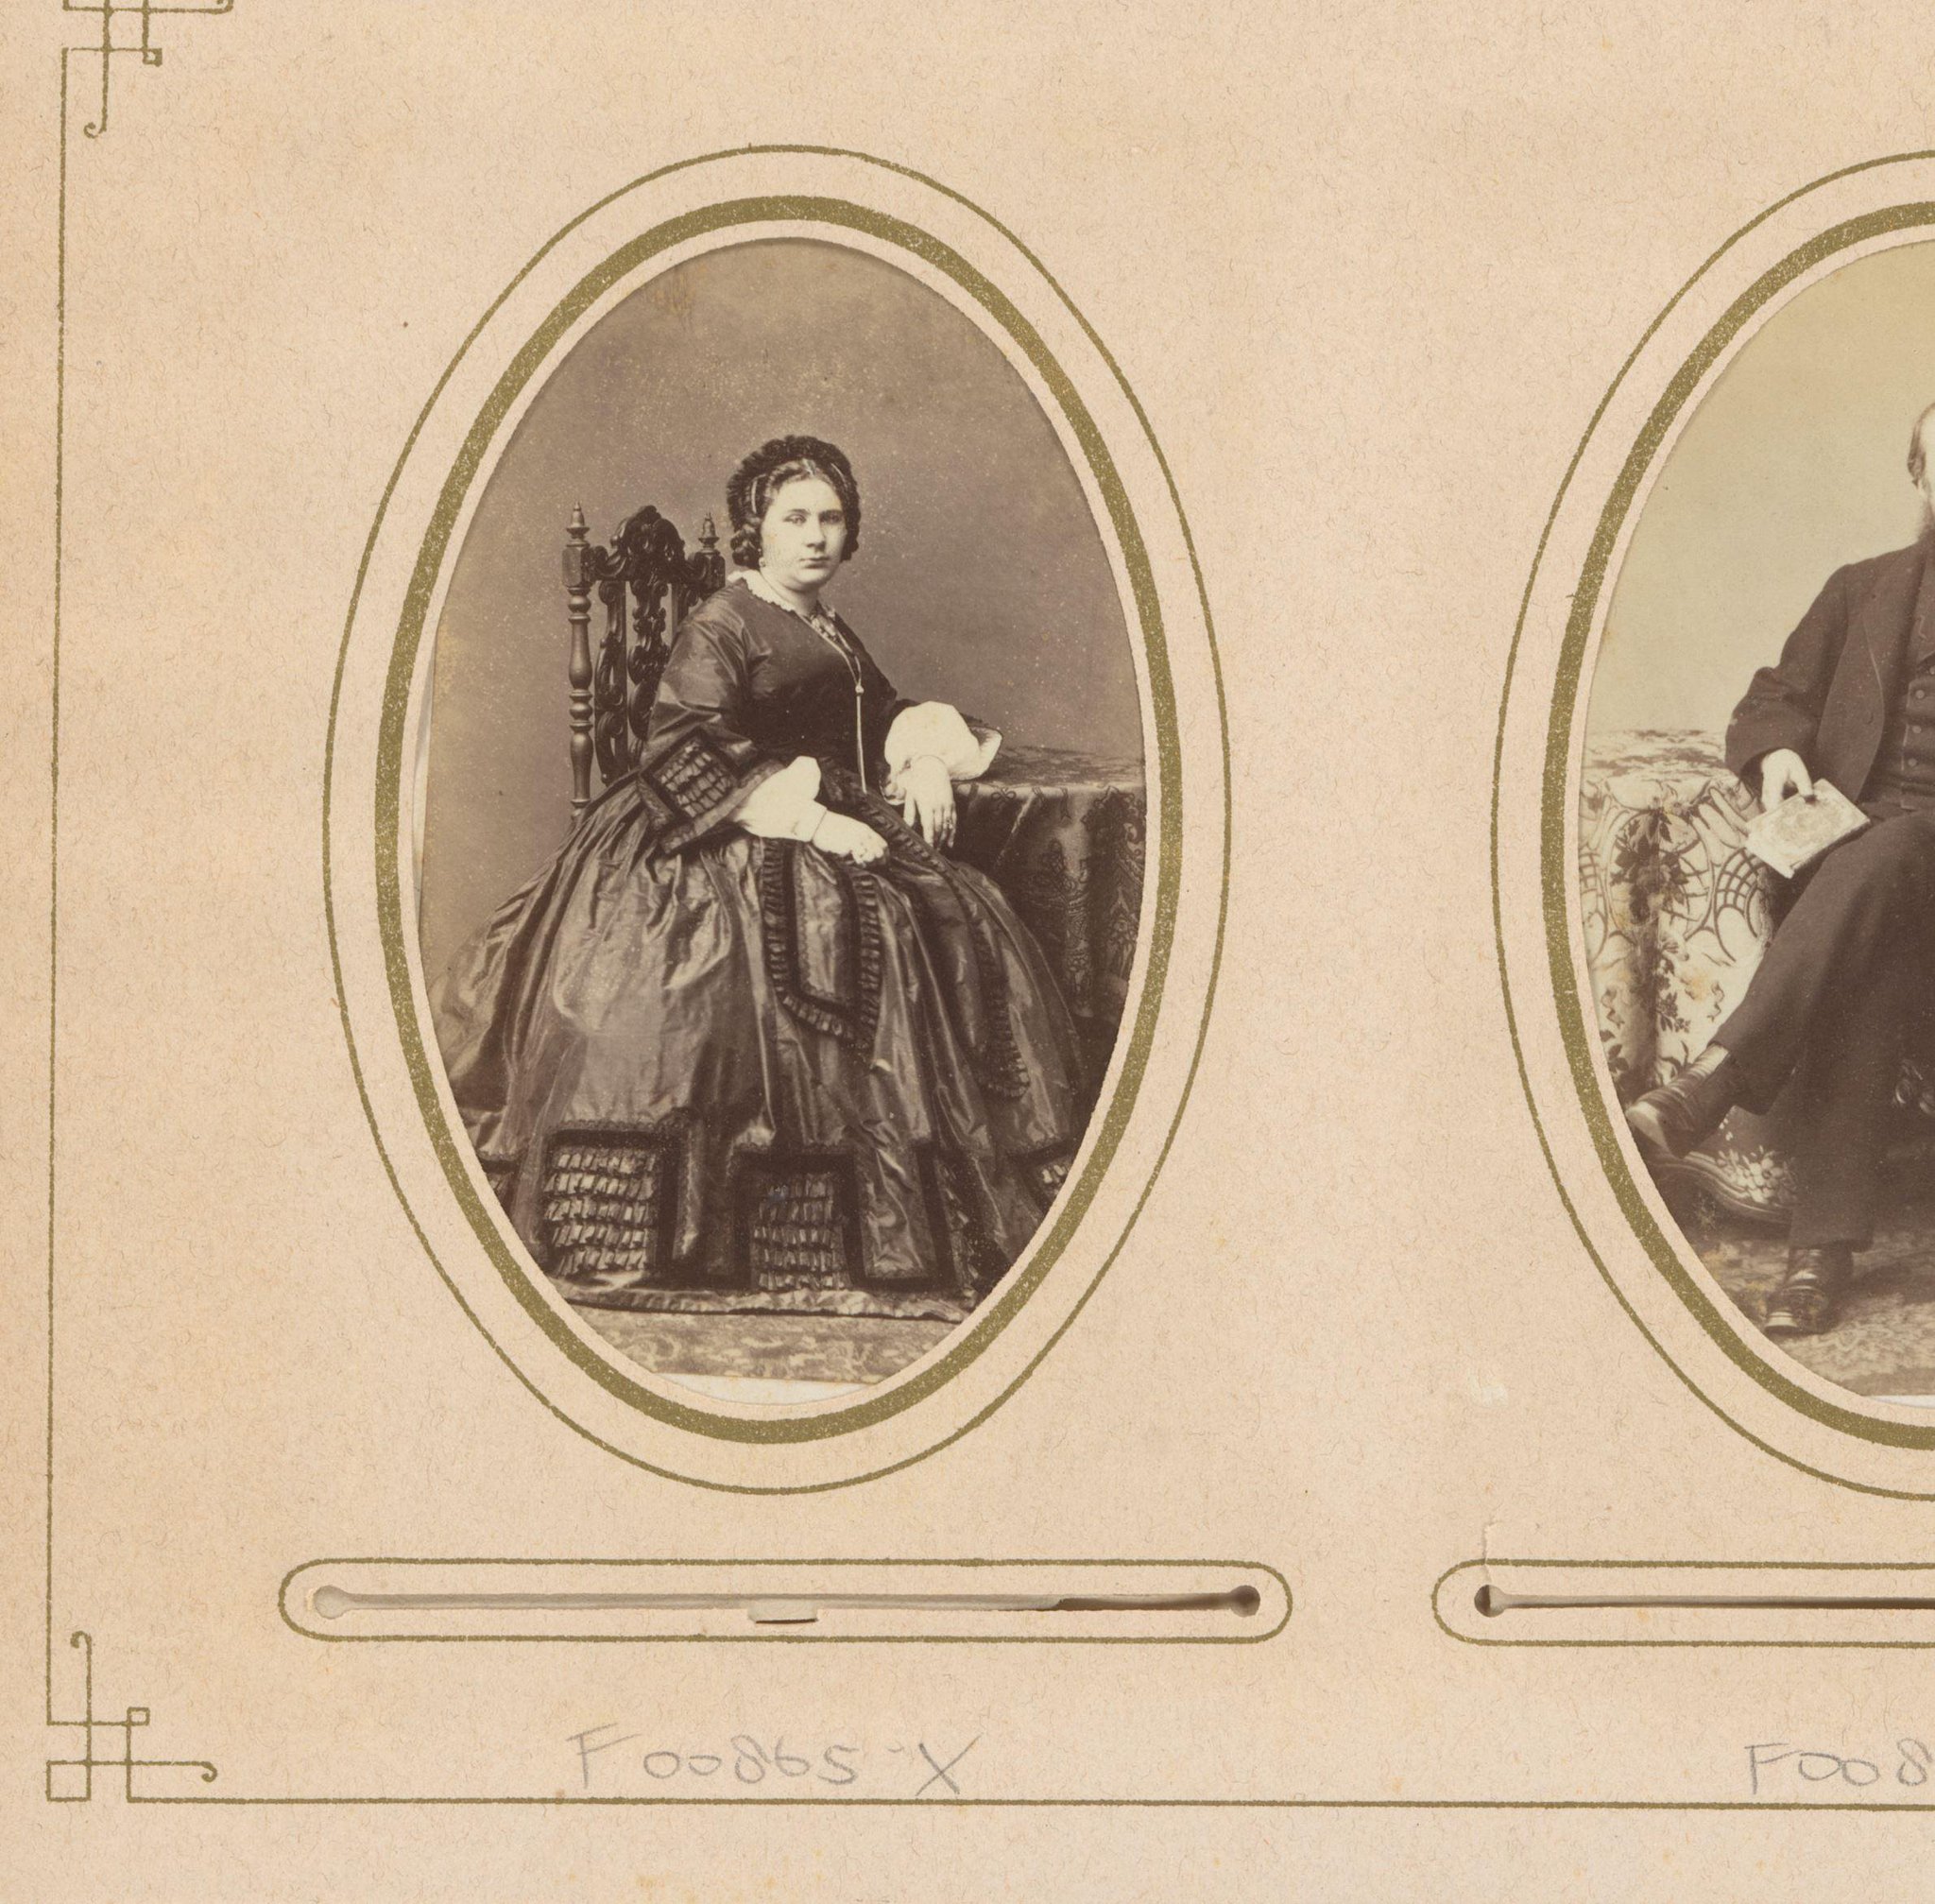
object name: album leaf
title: Portret van een vrouw met muts, zittend aan een tafel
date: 1865-1875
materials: cardboard, photographic support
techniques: albumen print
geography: brussels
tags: sitting figure - aa - female human figure, historical persons - bb - woman, head-gear: cap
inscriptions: inscription: ‘ATELIER DE PHOTOGRAPHIE/ BILLOTTE FRÈRES,/ 9, rue de la Reine,/ près la Place de la Monnaie,/ BRUXELLES.’